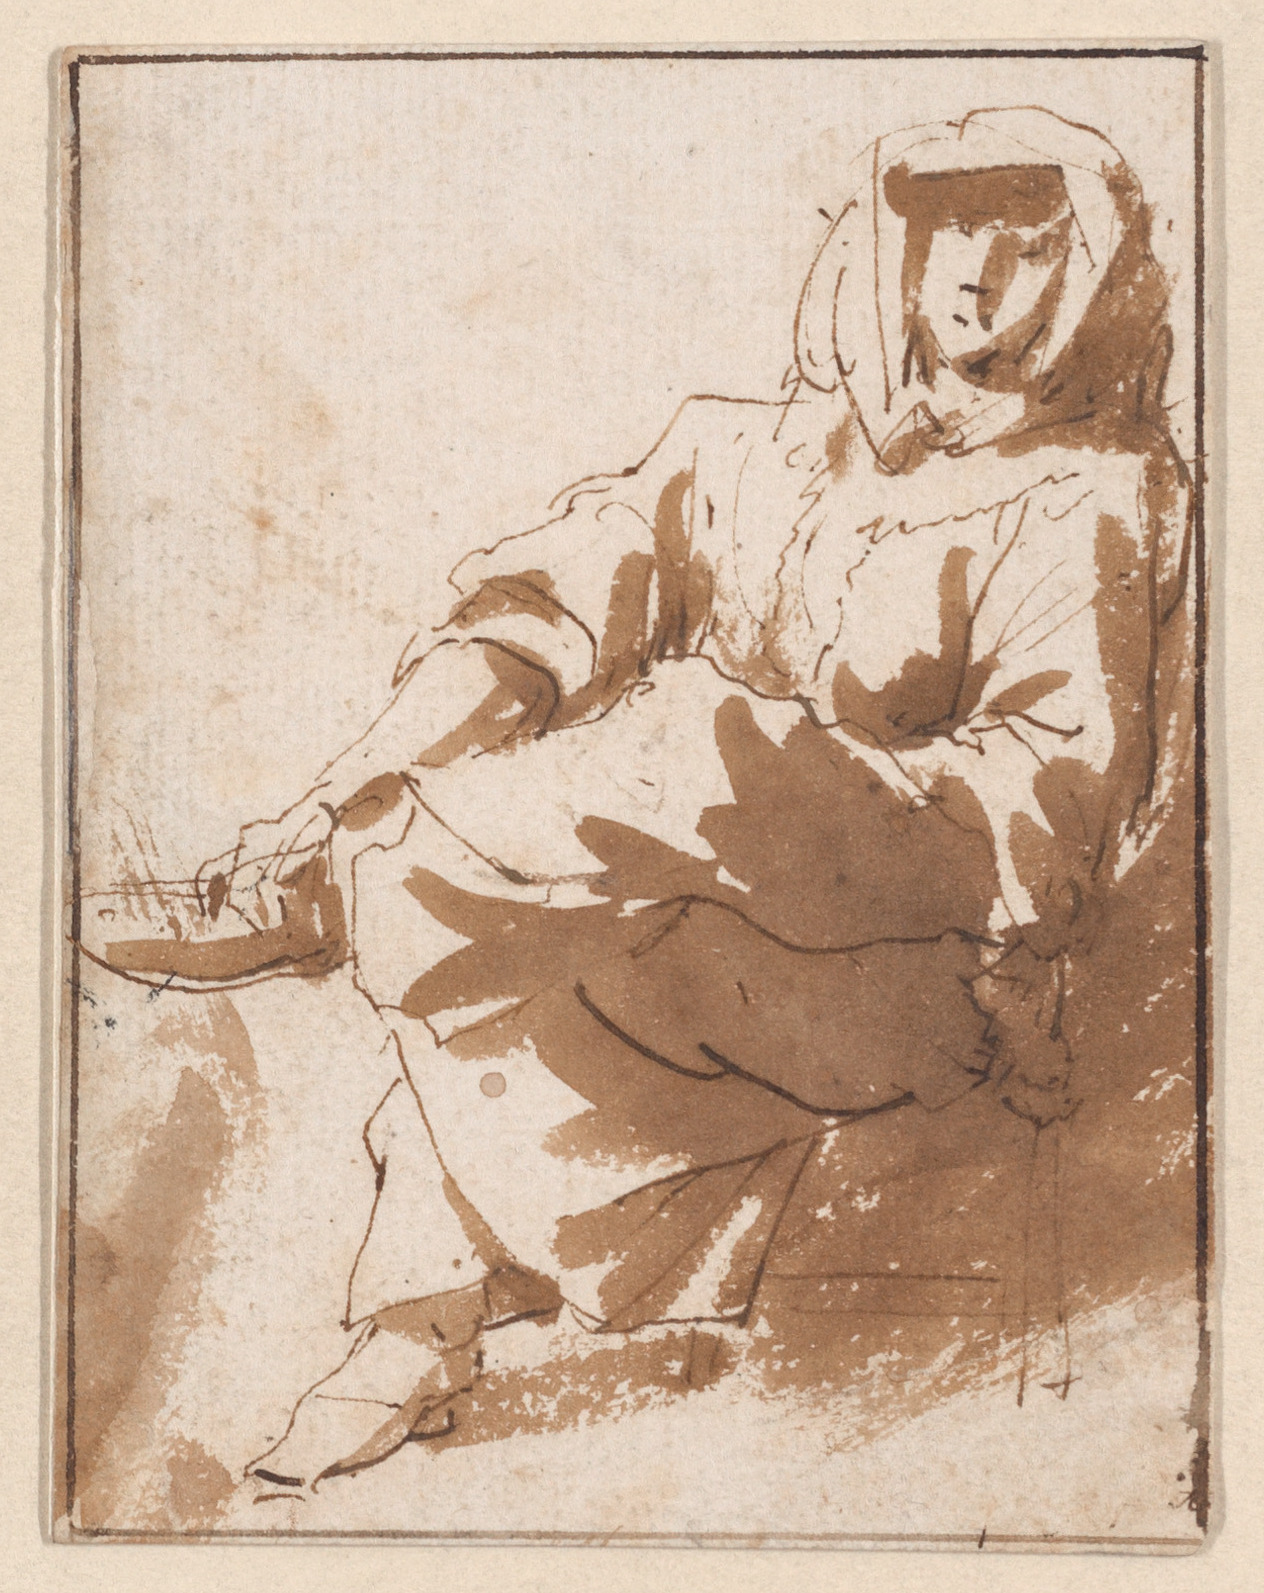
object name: drawing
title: A Seated Lady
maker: jan de bisschop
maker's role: artist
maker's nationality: dutch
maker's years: 1628-1671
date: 1634-1666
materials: ink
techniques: brush, pen, wash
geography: netherlands